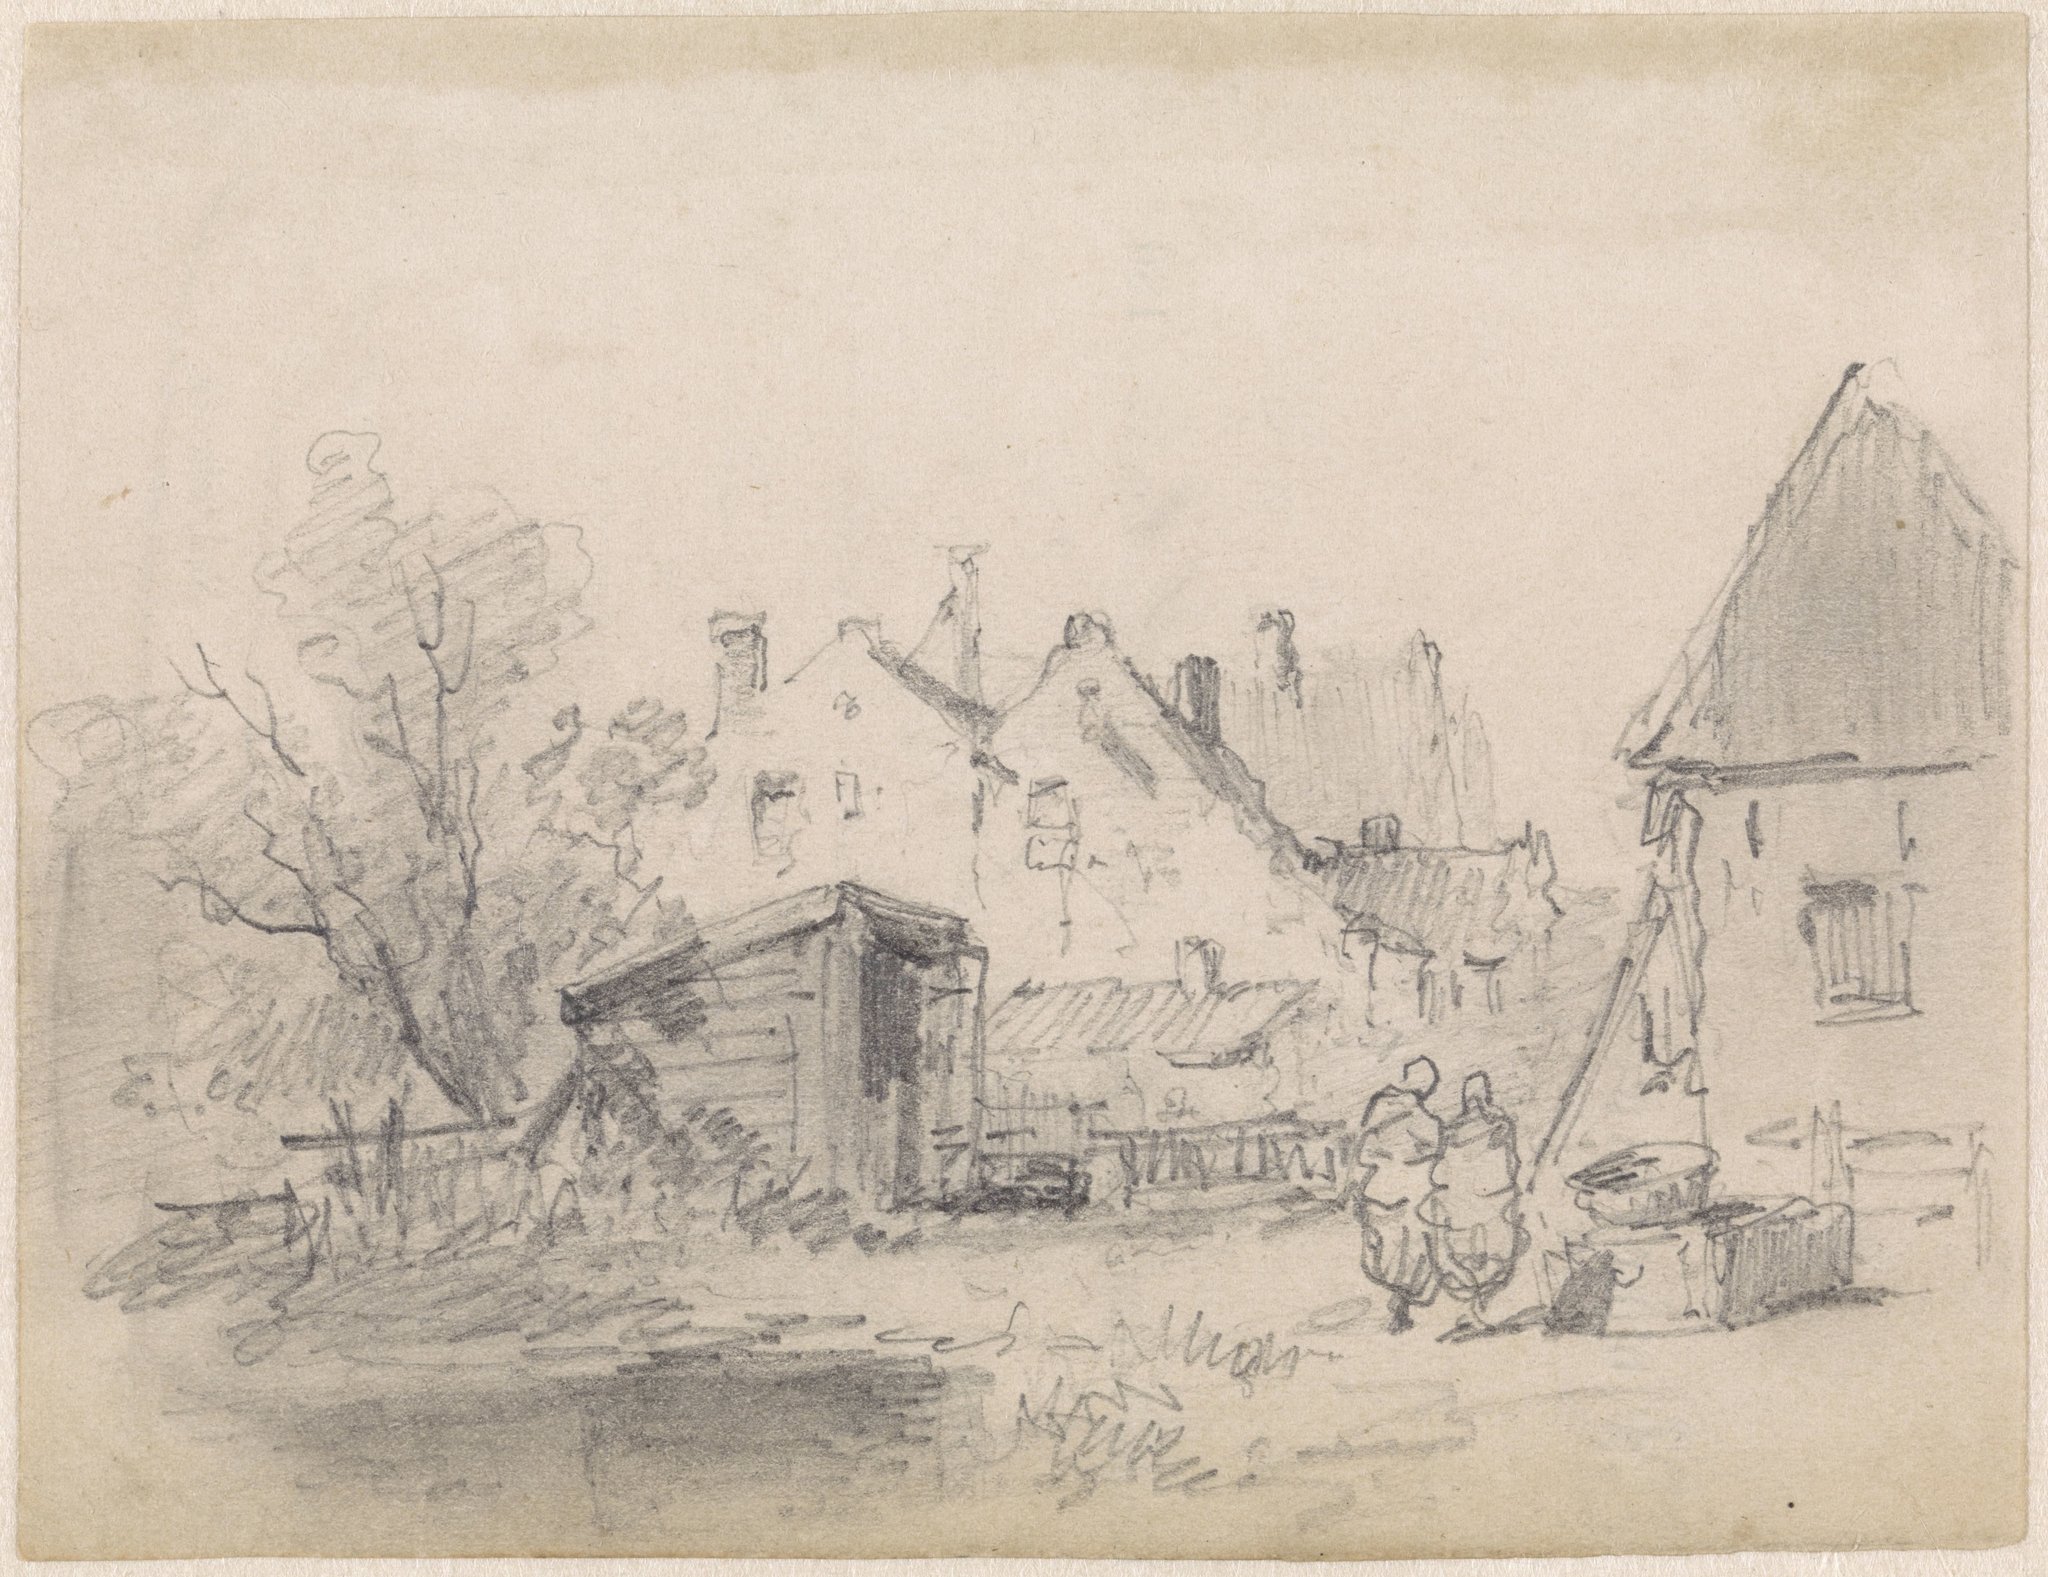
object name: drawing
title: Gezicht op huizen aan de rand van een stad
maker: adrianus eversen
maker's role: draughtsman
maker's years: 1818-1897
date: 1828-1897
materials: paper, pencil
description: Gezicht op huizen aan de rand van een stad. Op een convocatie van Arti, gesigneerd door C. Springer.